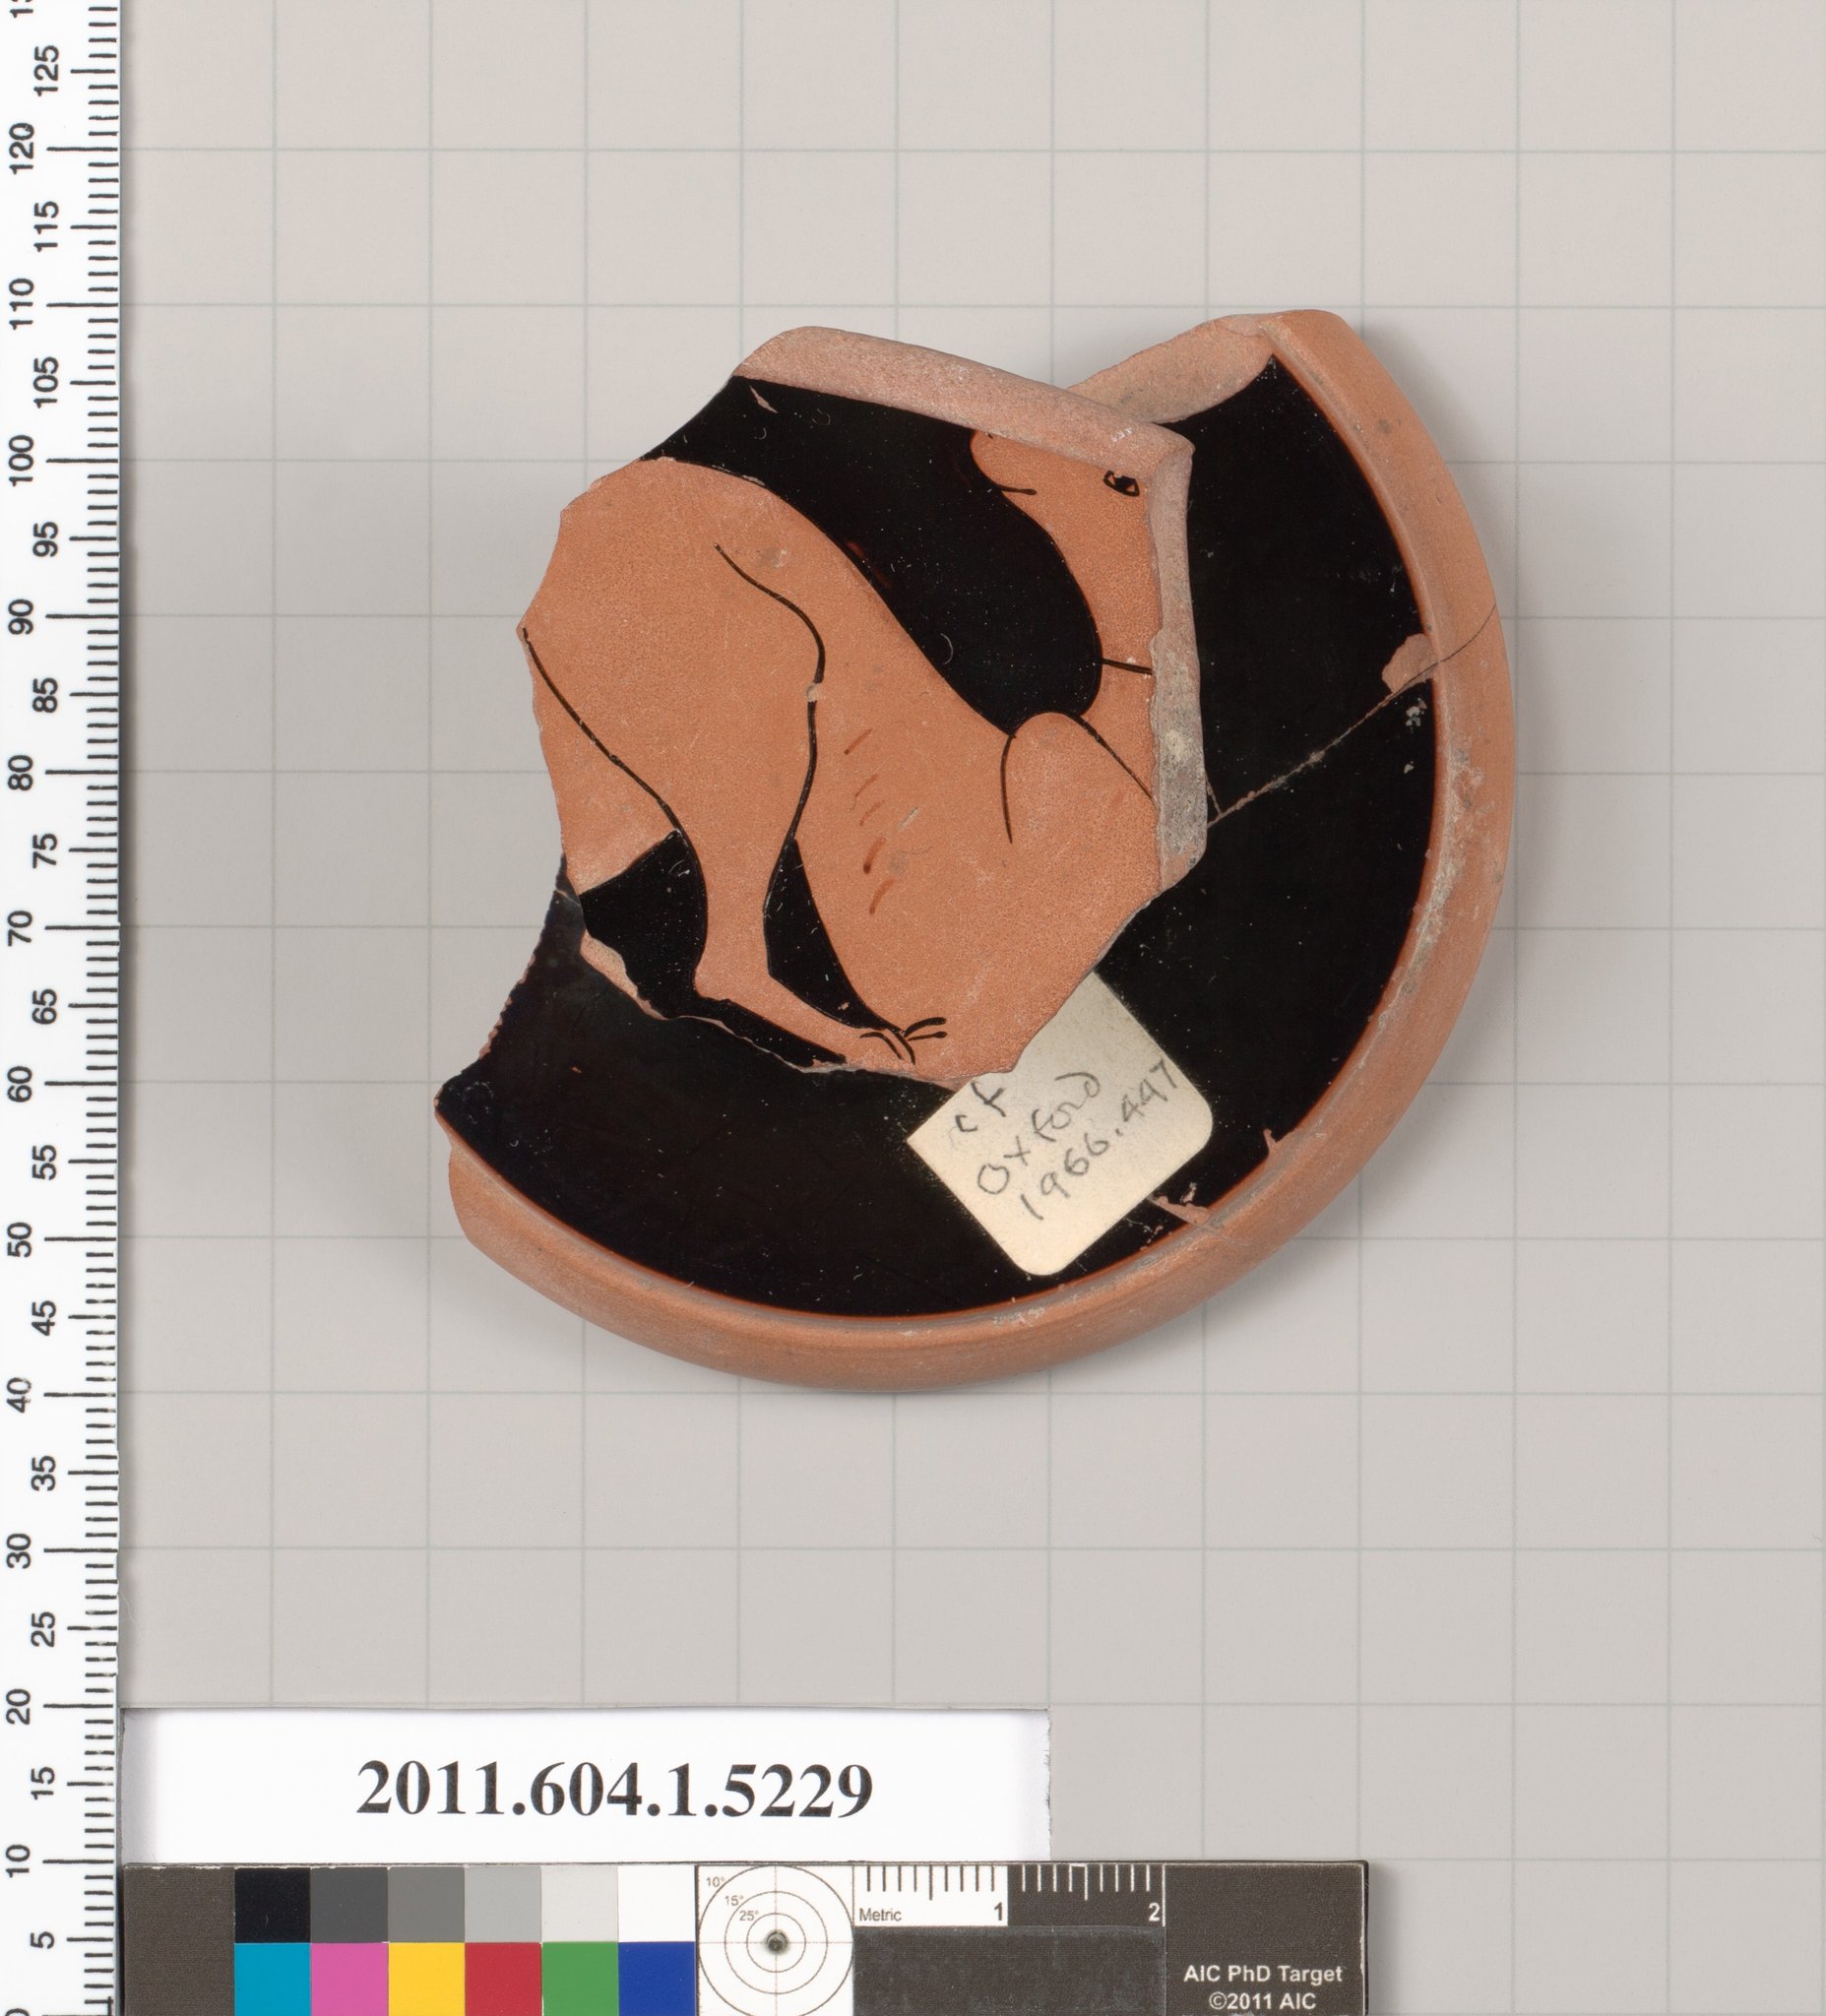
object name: kylix fragment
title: Terracotta fragment of a kylix (drinking cup)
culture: greek, attic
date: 520-500 BCE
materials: terracotta